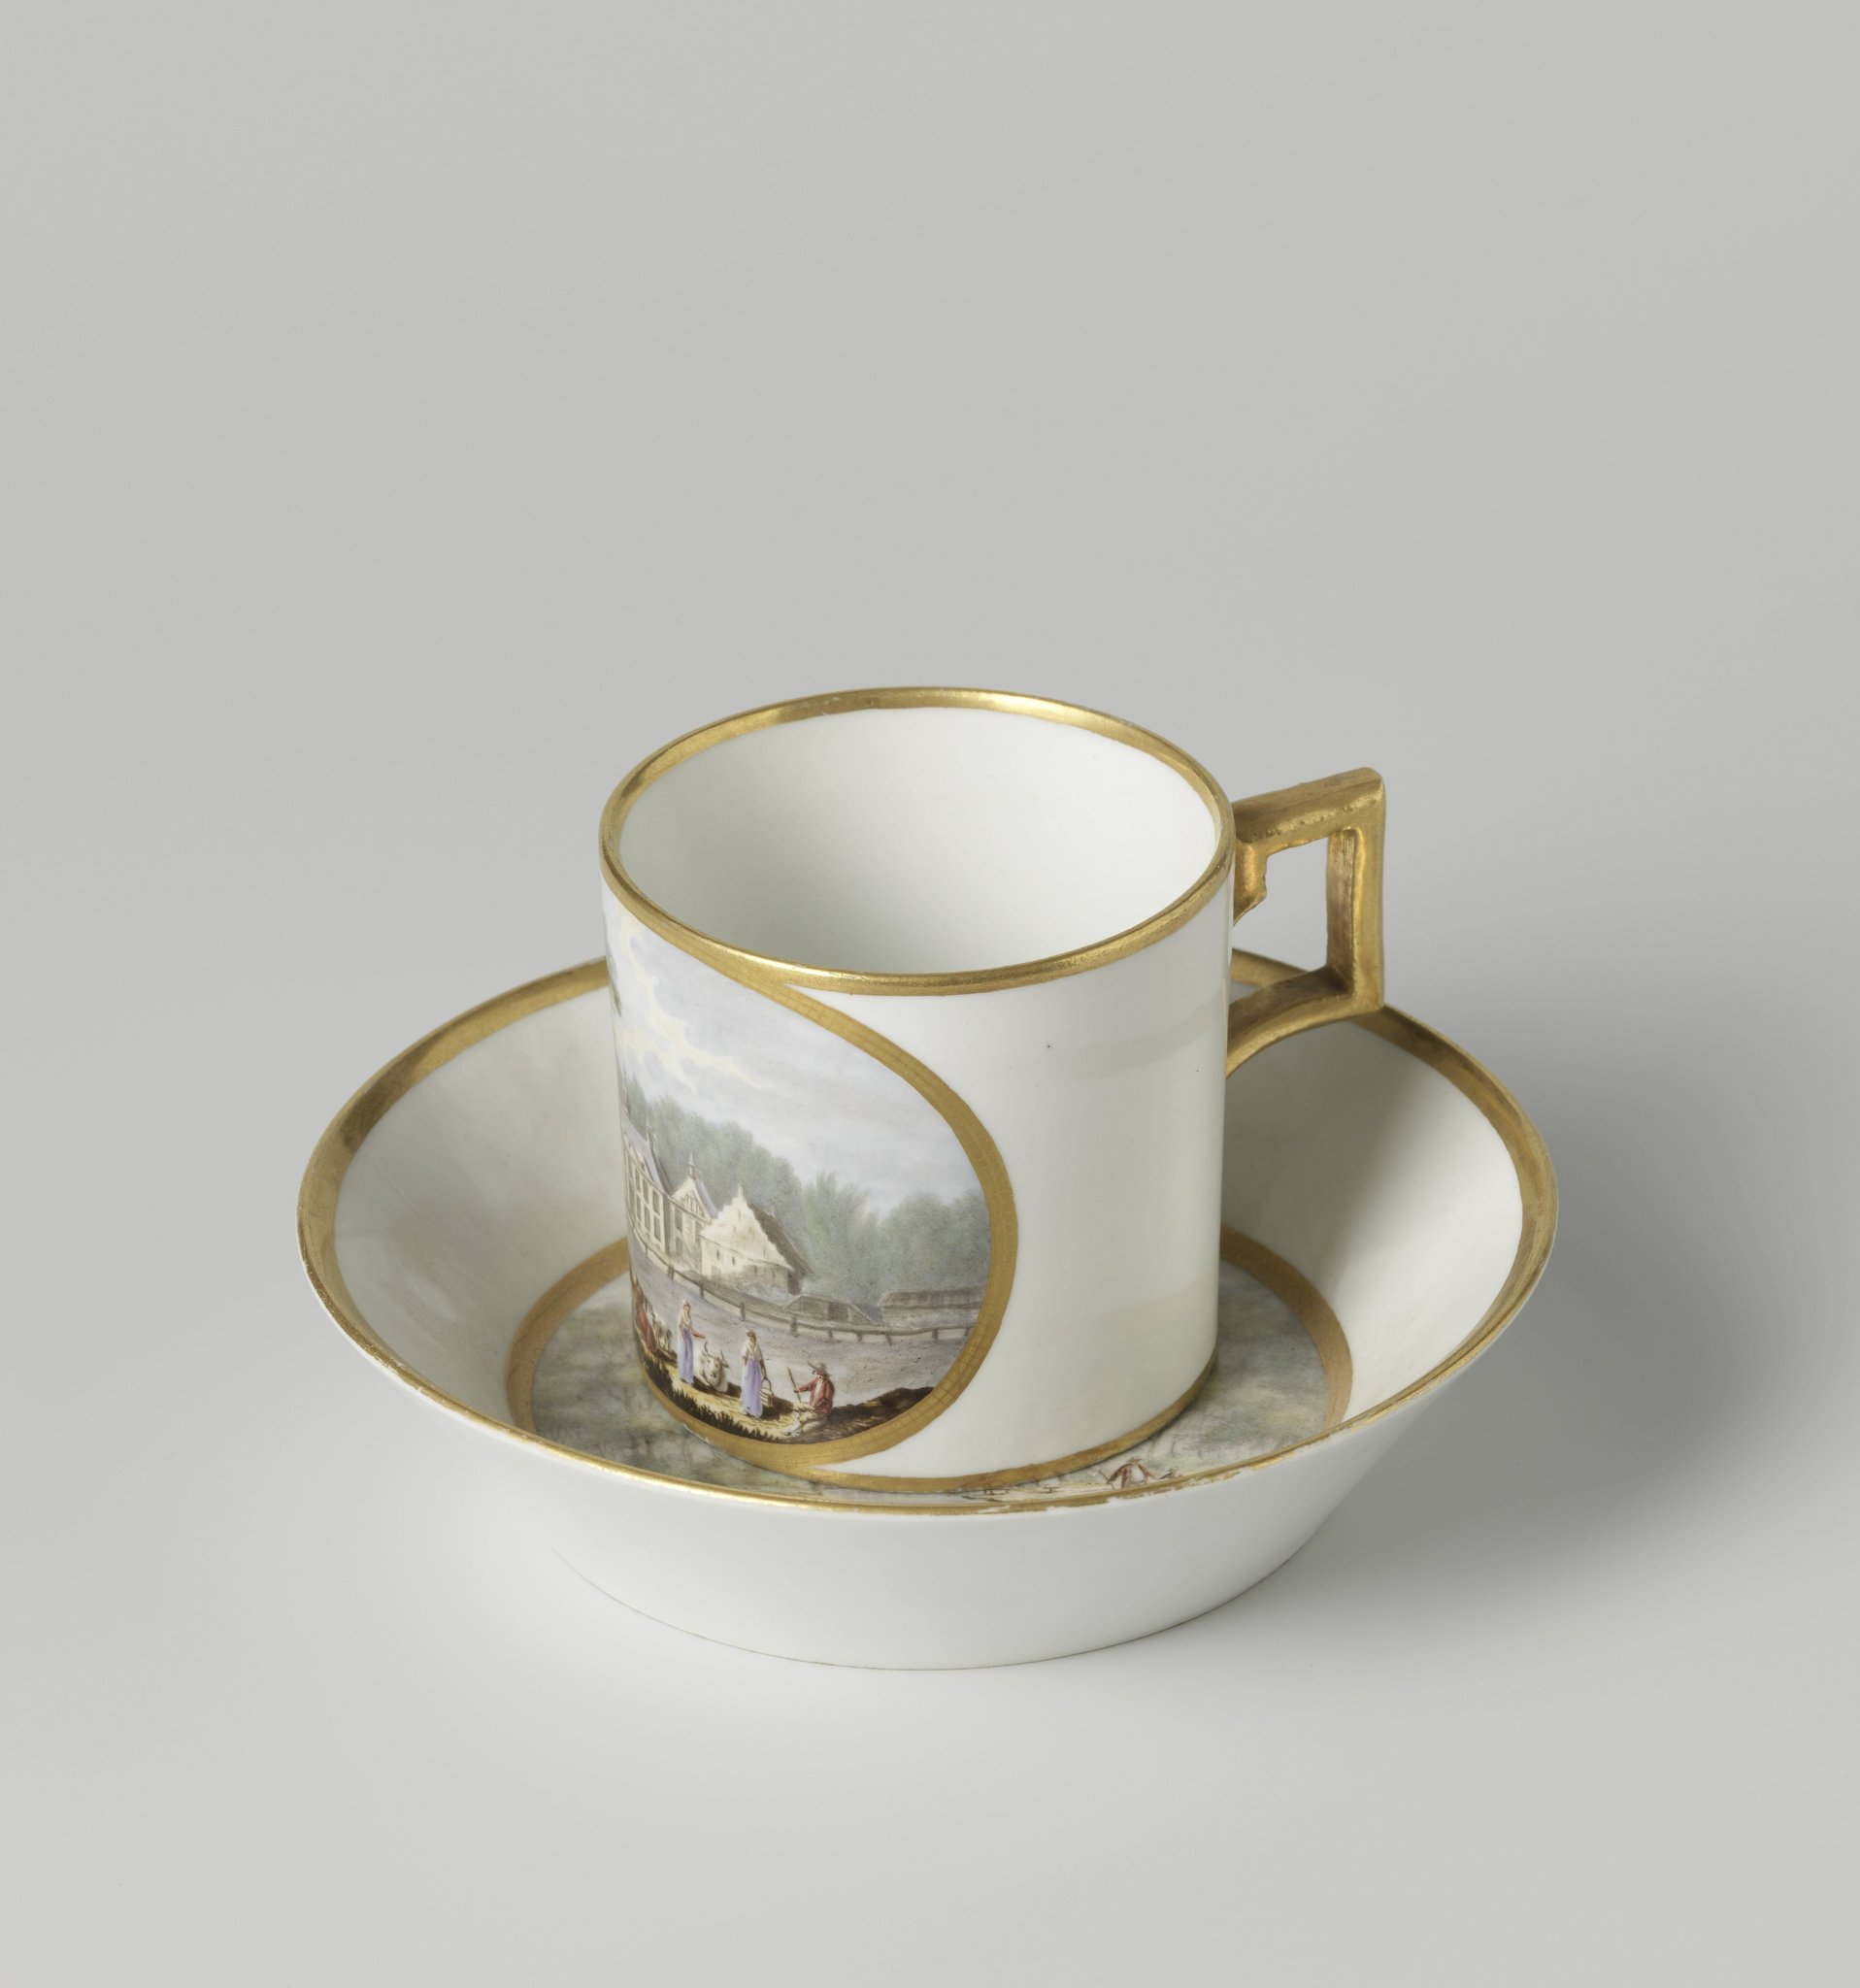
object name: cup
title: Cup with a landscape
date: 1790-1800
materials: glaze, gold, paint, porcelain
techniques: firing, forming, gilding, turning, vitrification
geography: furstenberg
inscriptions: mark: ‘F/ 10N’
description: Kop van porselein met een cilindrische wand en hoekig oor, beschilderd op het glazuur in emailkleuren en goud. Op de buitenwand een medaillon met landschap met een landhuis en op de voorgrond een man en twee vrouwen bij een kleine kudde koeien. Gouden lijn boven de voet; gouden rand en oor. Gemerkt op de onderzijde met de F, 10 en 10N.